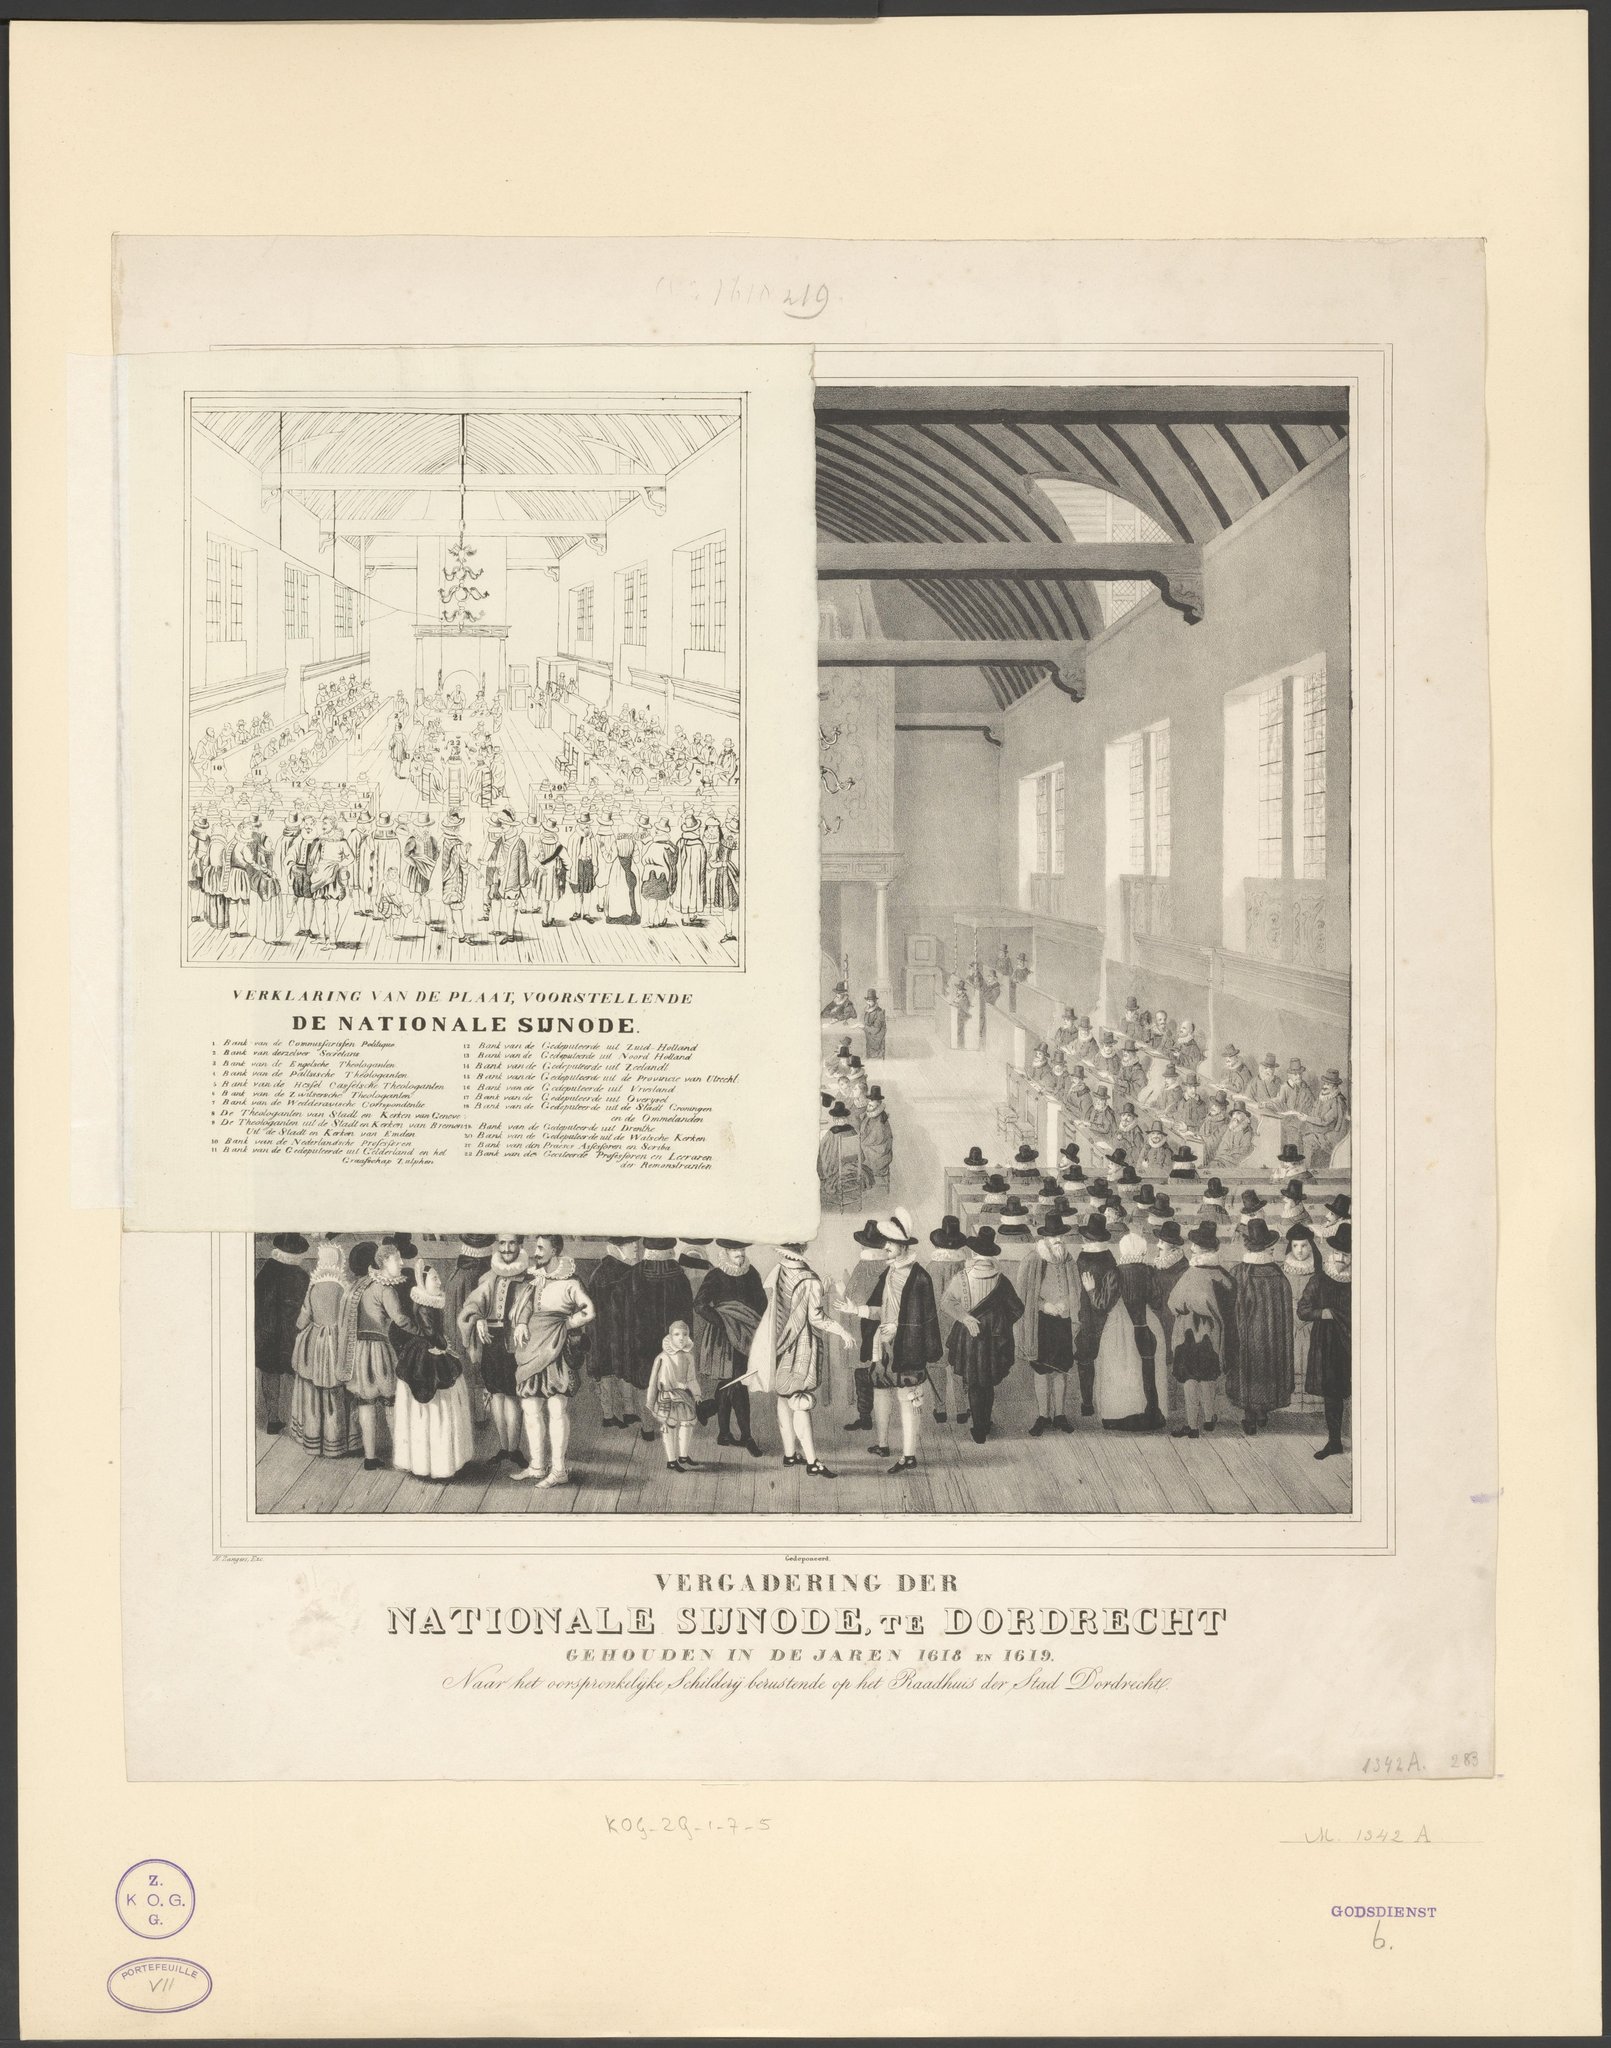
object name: print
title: Synode van Dordrecht, 1618-1619 met sleutel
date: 1800-1849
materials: paper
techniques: lithograph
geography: dordrecht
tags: organizations, assemblies, etc. in protestant churches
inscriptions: stamp, stamp, collector's mark: Lugt 1641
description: De opening van de nationale synode te Dordrecht, 13 november 1618. Overzicht van de vergadering in de grote zaal in de Kloveniersdoelen met alle aanwezigen, op de voorgrond toeschouwers. Met verklarende sleutel. Onderwerpsrubrieken binnen de Atlas Zeden en Gewoonten: Godsdienst, Ned. Hervormden, (Oudtijds Gereformeerden), Synode van Dordrecht.